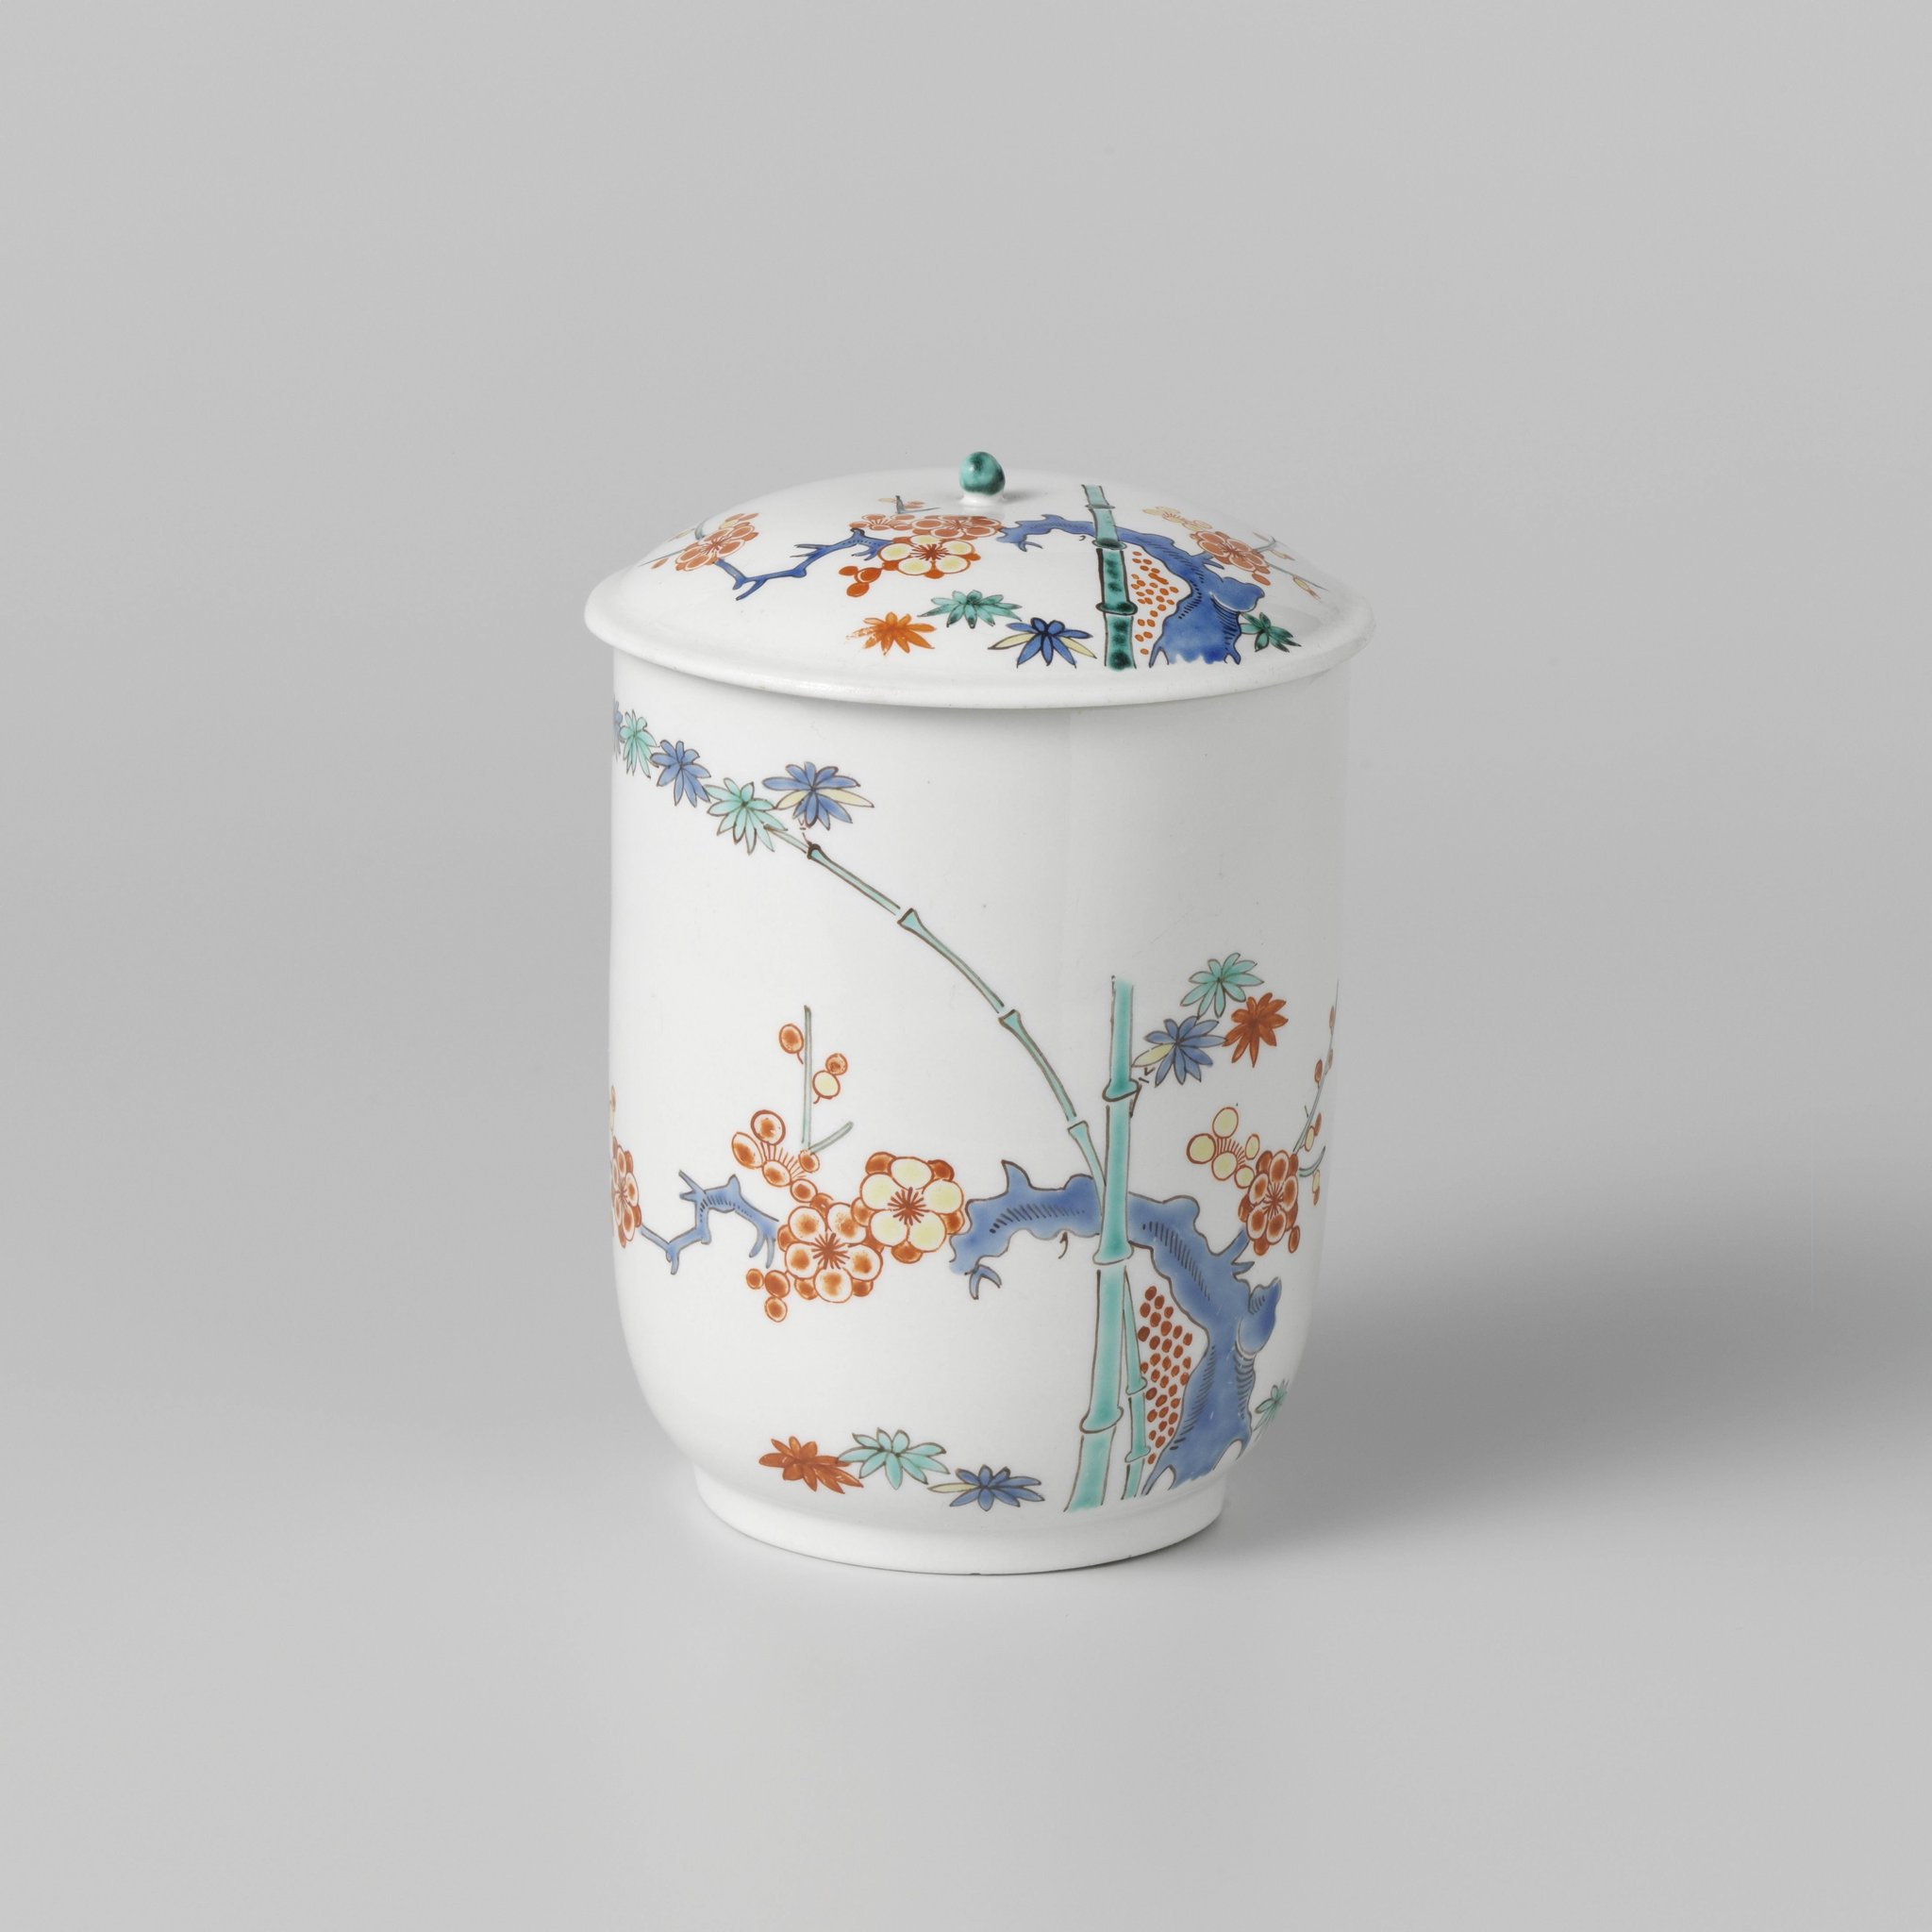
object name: covered jar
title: Pot with flowering plants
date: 1730-1750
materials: glaze, paint, porcelain, soft paste porcelain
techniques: firing, forming, turning, vitrification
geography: chantilly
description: Mug. Worcester, c. 1750 - 1775. Small jar and cover. Chantilly, c. 1730 - 1750.